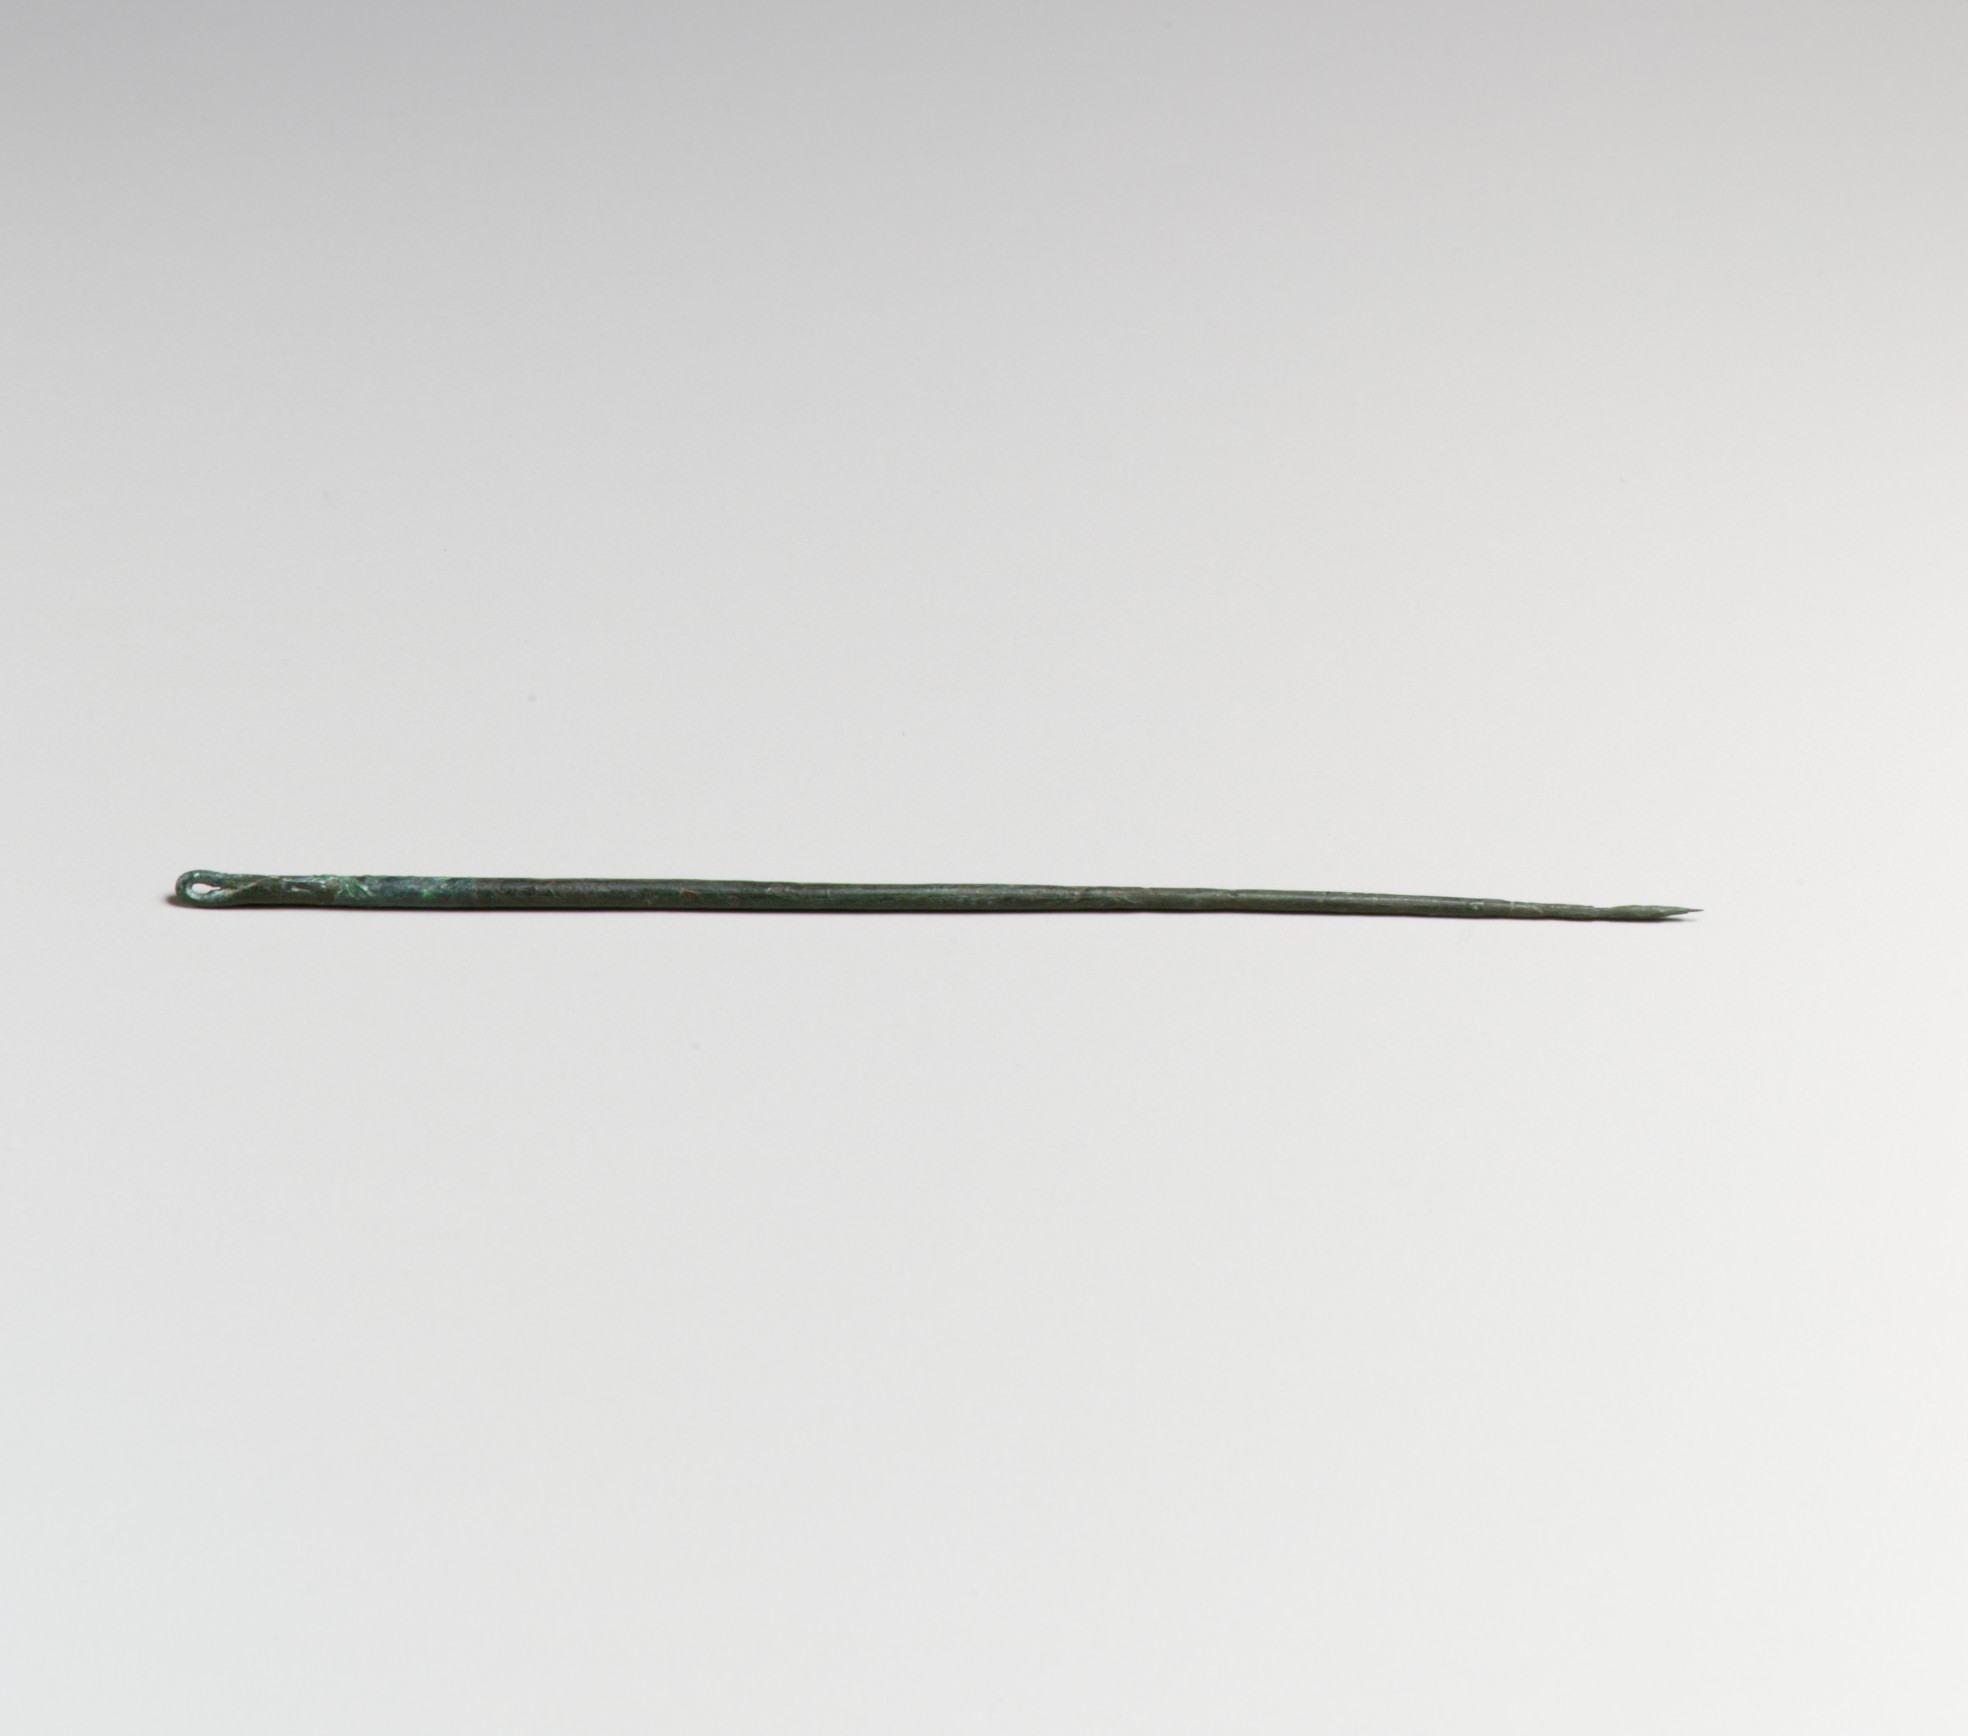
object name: needle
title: Bronze needle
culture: minoan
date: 2000-1001 BCE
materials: bronze